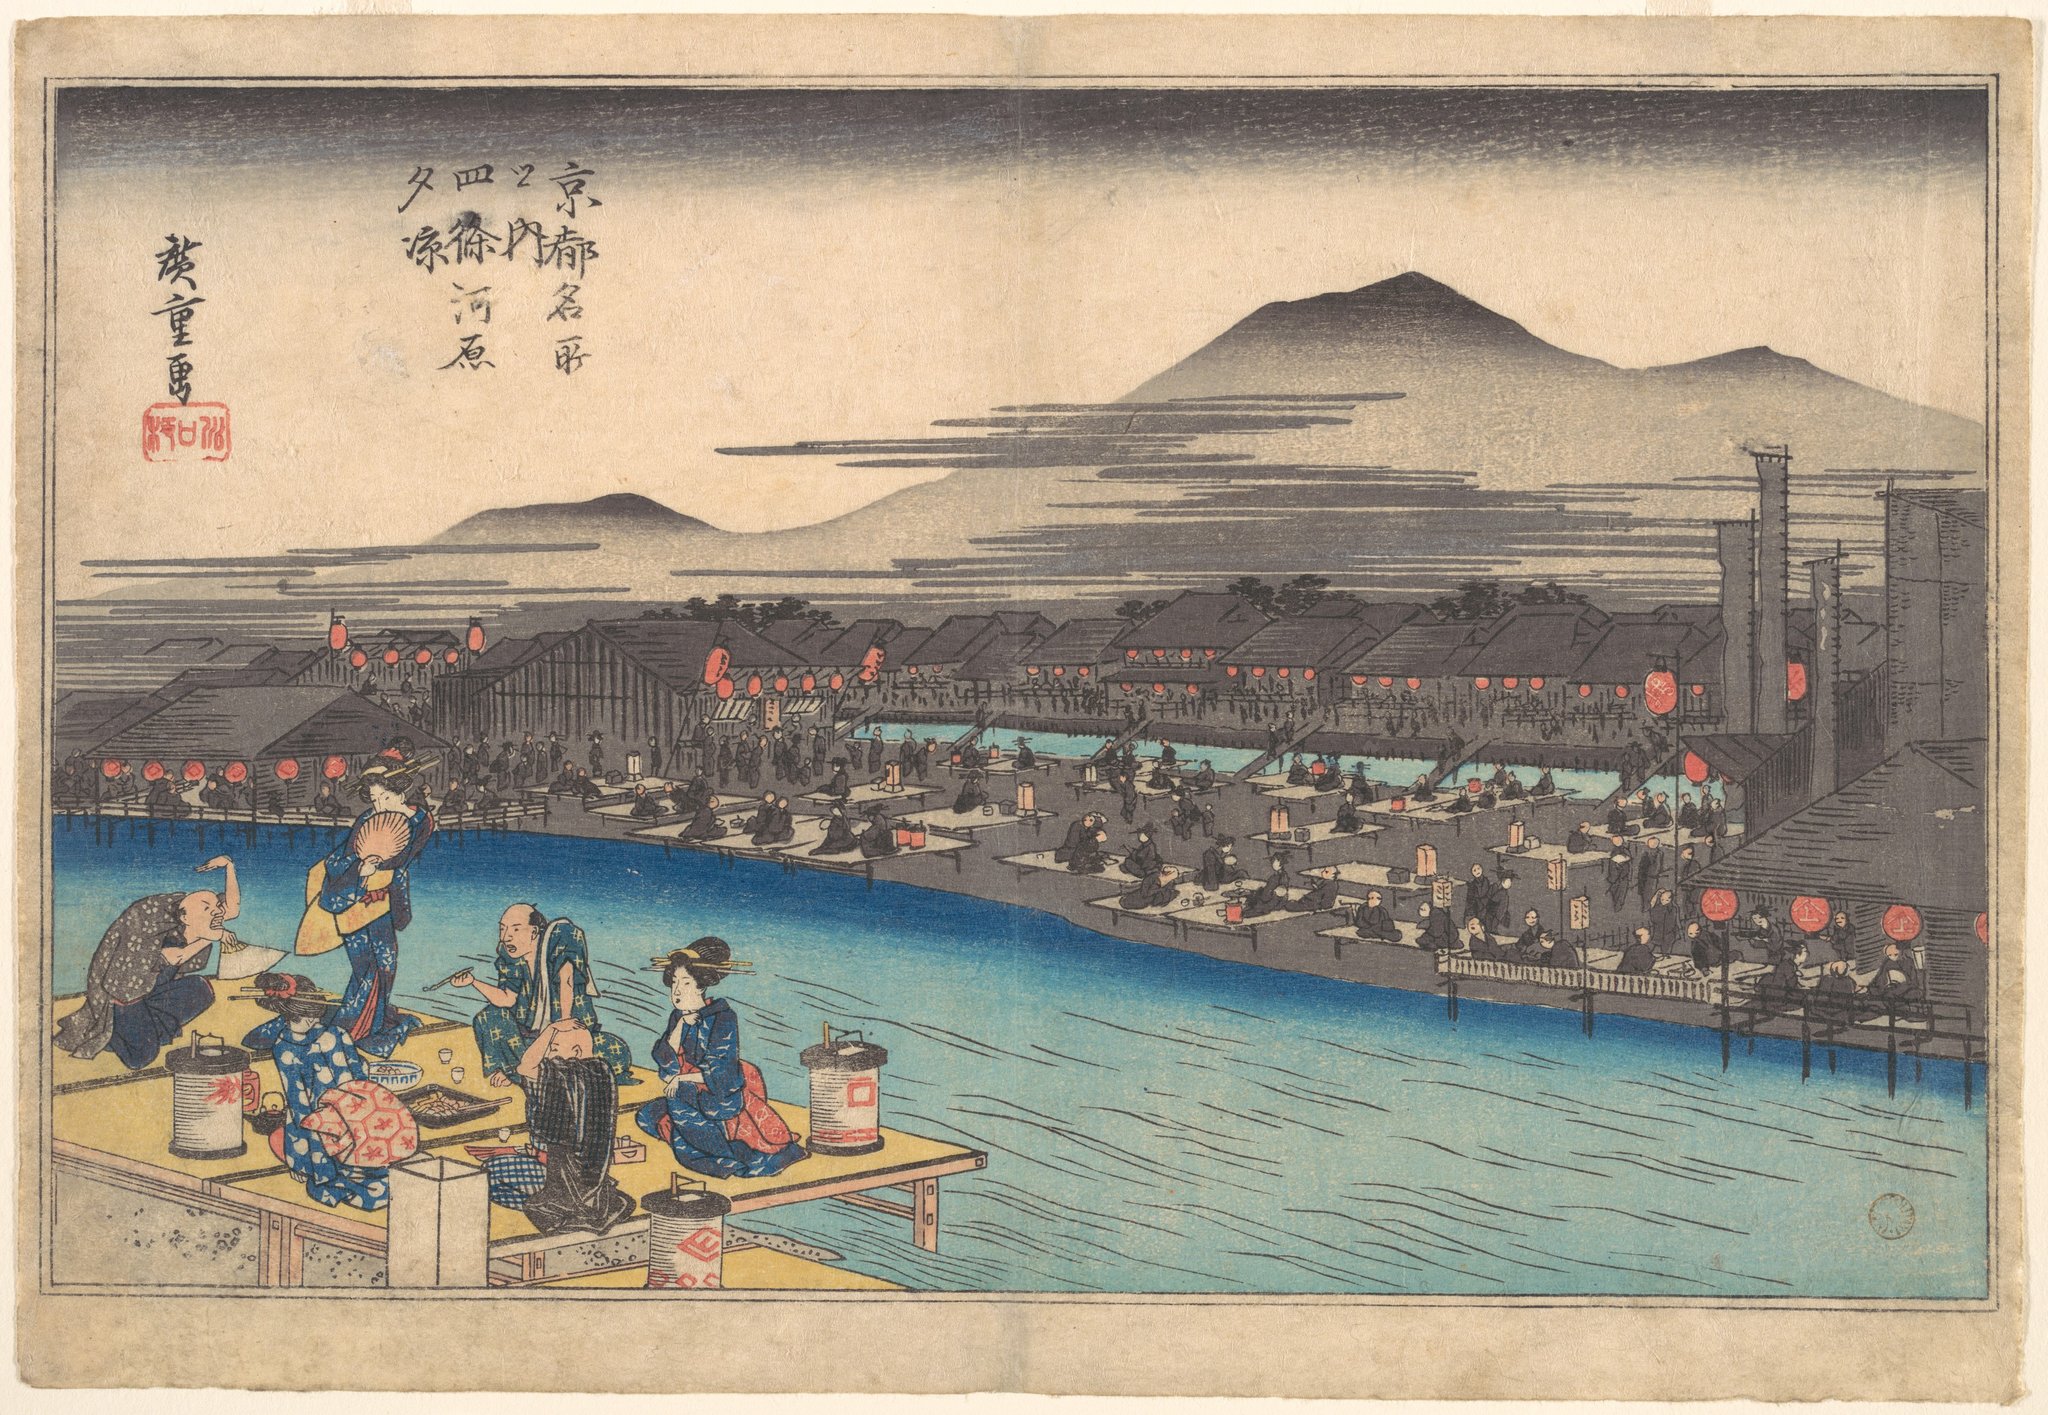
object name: print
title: Cooling off in the Evening at Shijogawara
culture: japanese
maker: utagawa hiroshige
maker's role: artist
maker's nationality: japanese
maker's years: 1797-1858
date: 1834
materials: ink, paper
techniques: woodblock print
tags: men,women,rivers,eating